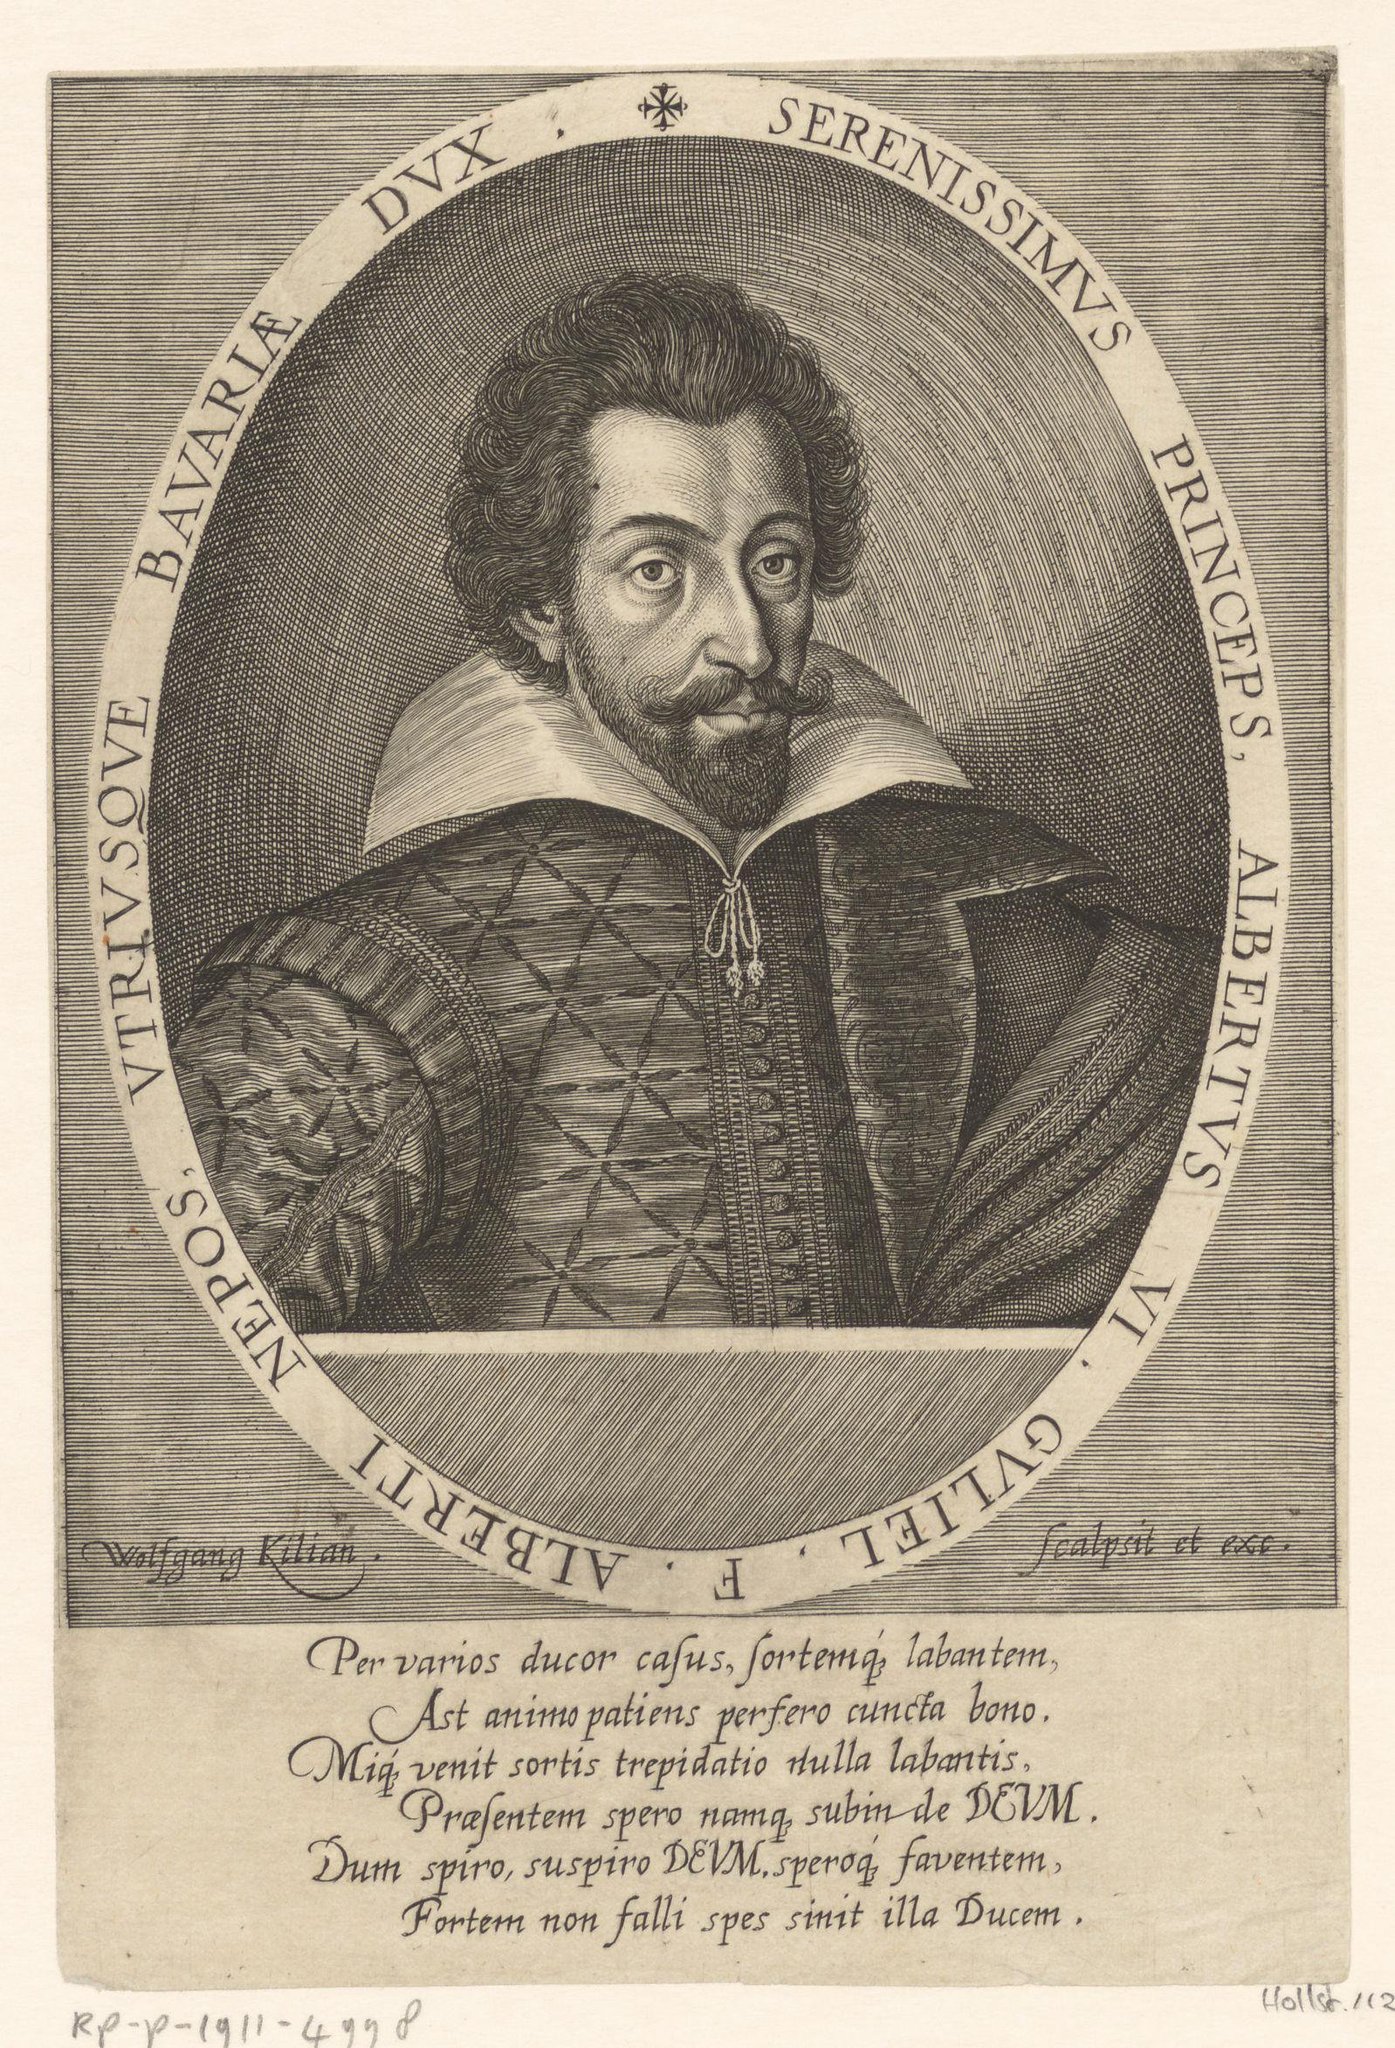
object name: print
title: Portret van Albrecht VI van Beieren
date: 1591-1662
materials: paper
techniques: engraving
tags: historical persons, regent, substitute ruler; viceroy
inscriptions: collector's mark: Lugt 2228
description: Tekst in het Latijn in de omlijsting en in de ondermarge.